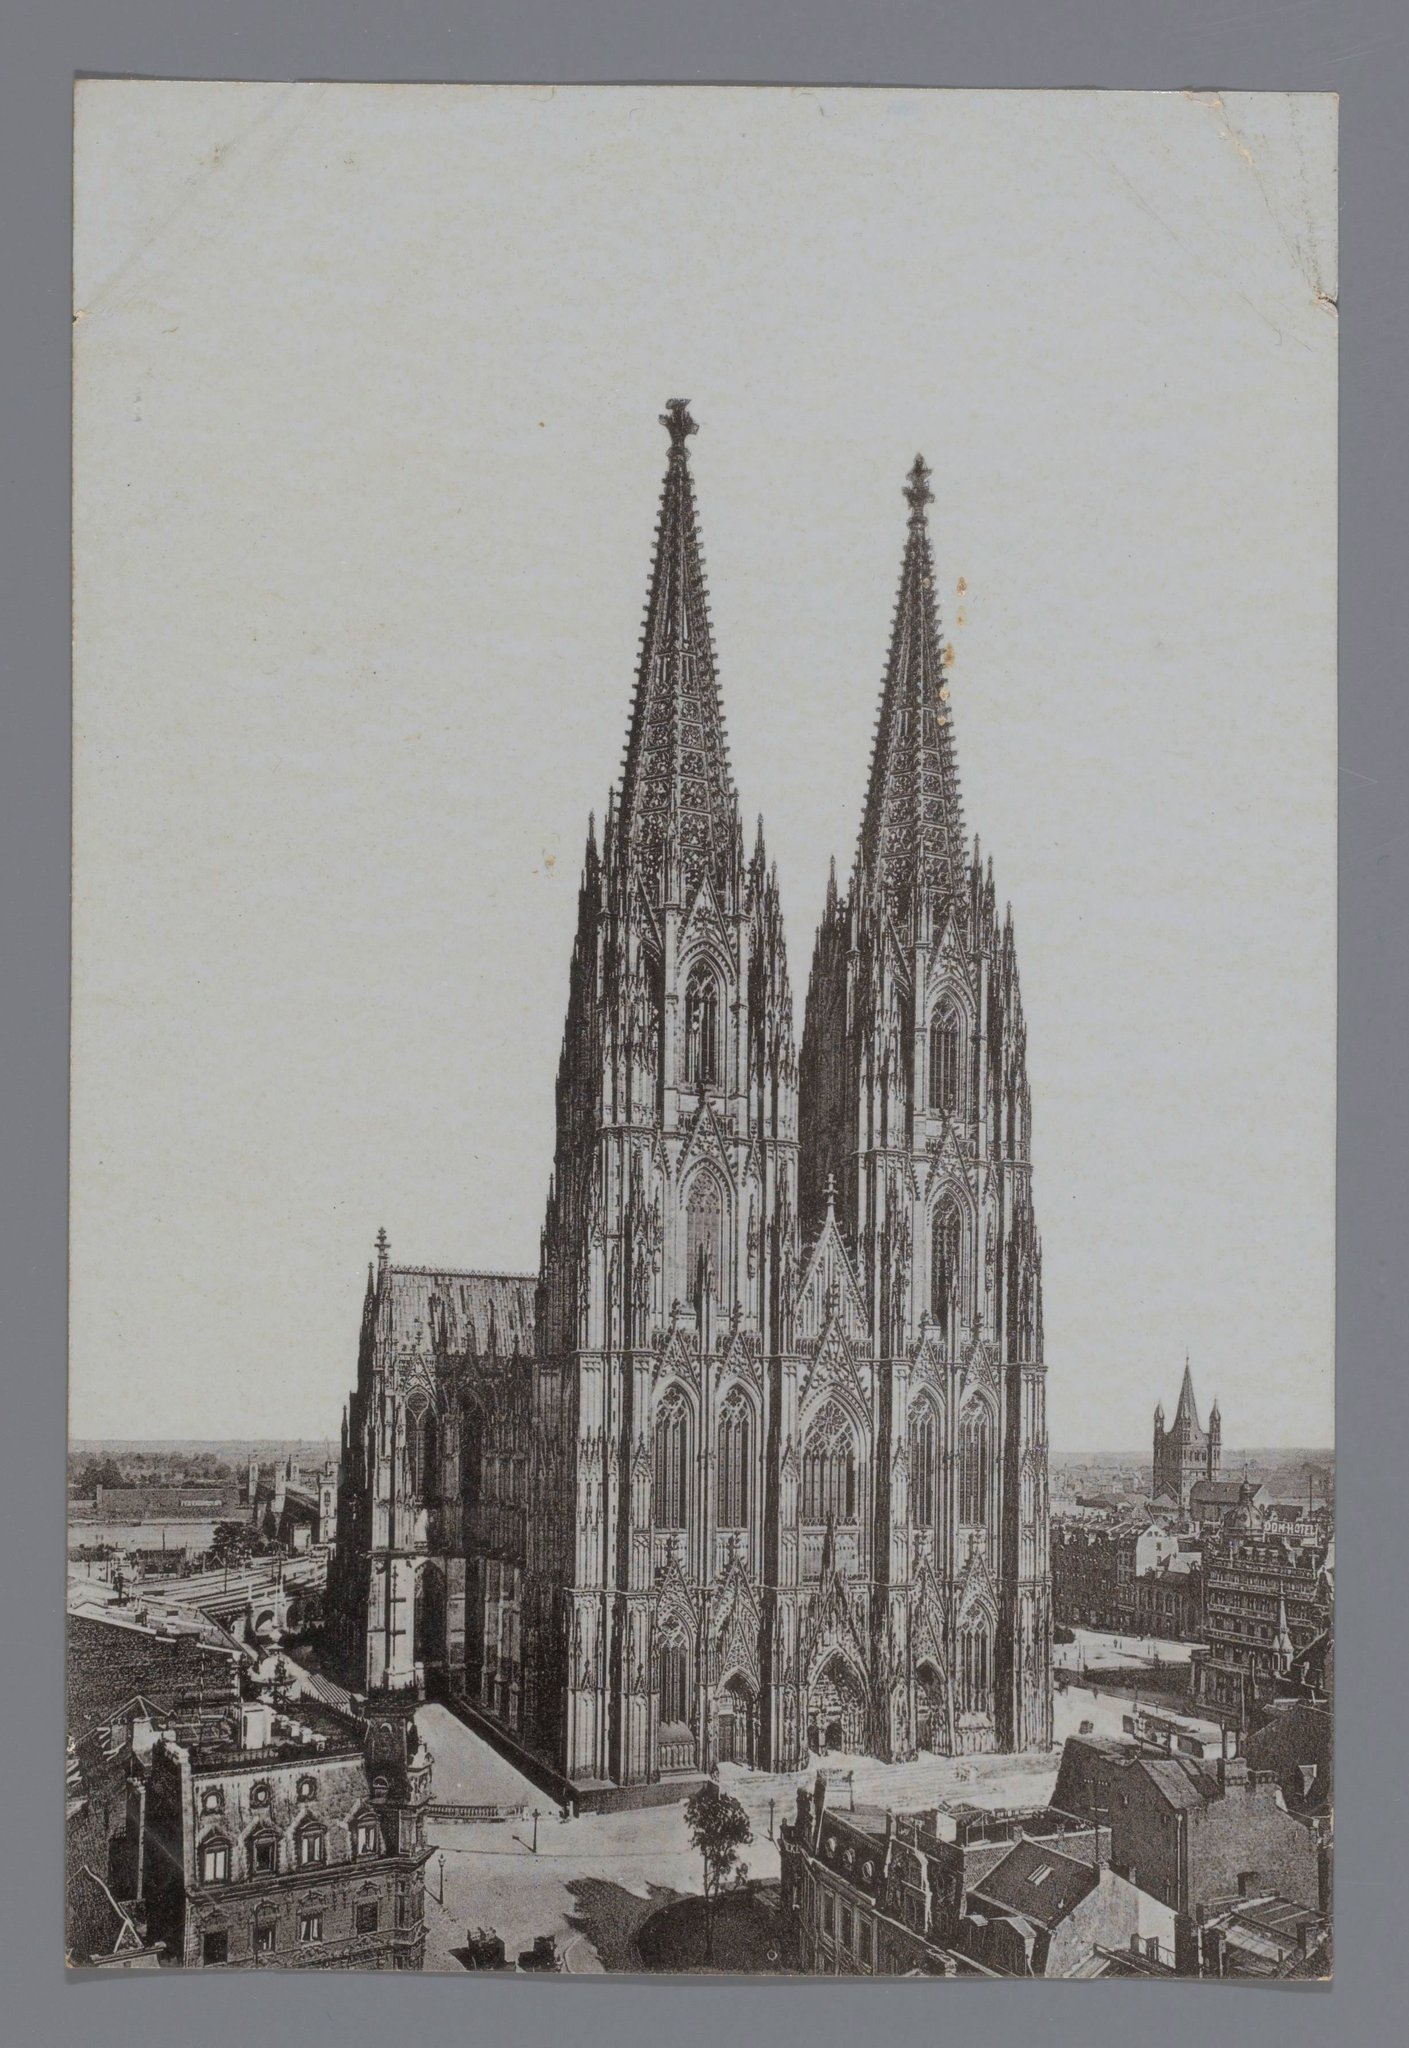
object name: photomechanical print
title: Dom van Keulen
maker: Anonymous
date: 1880-1910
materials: paper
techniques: photograph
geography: cologne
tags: church (exterior)